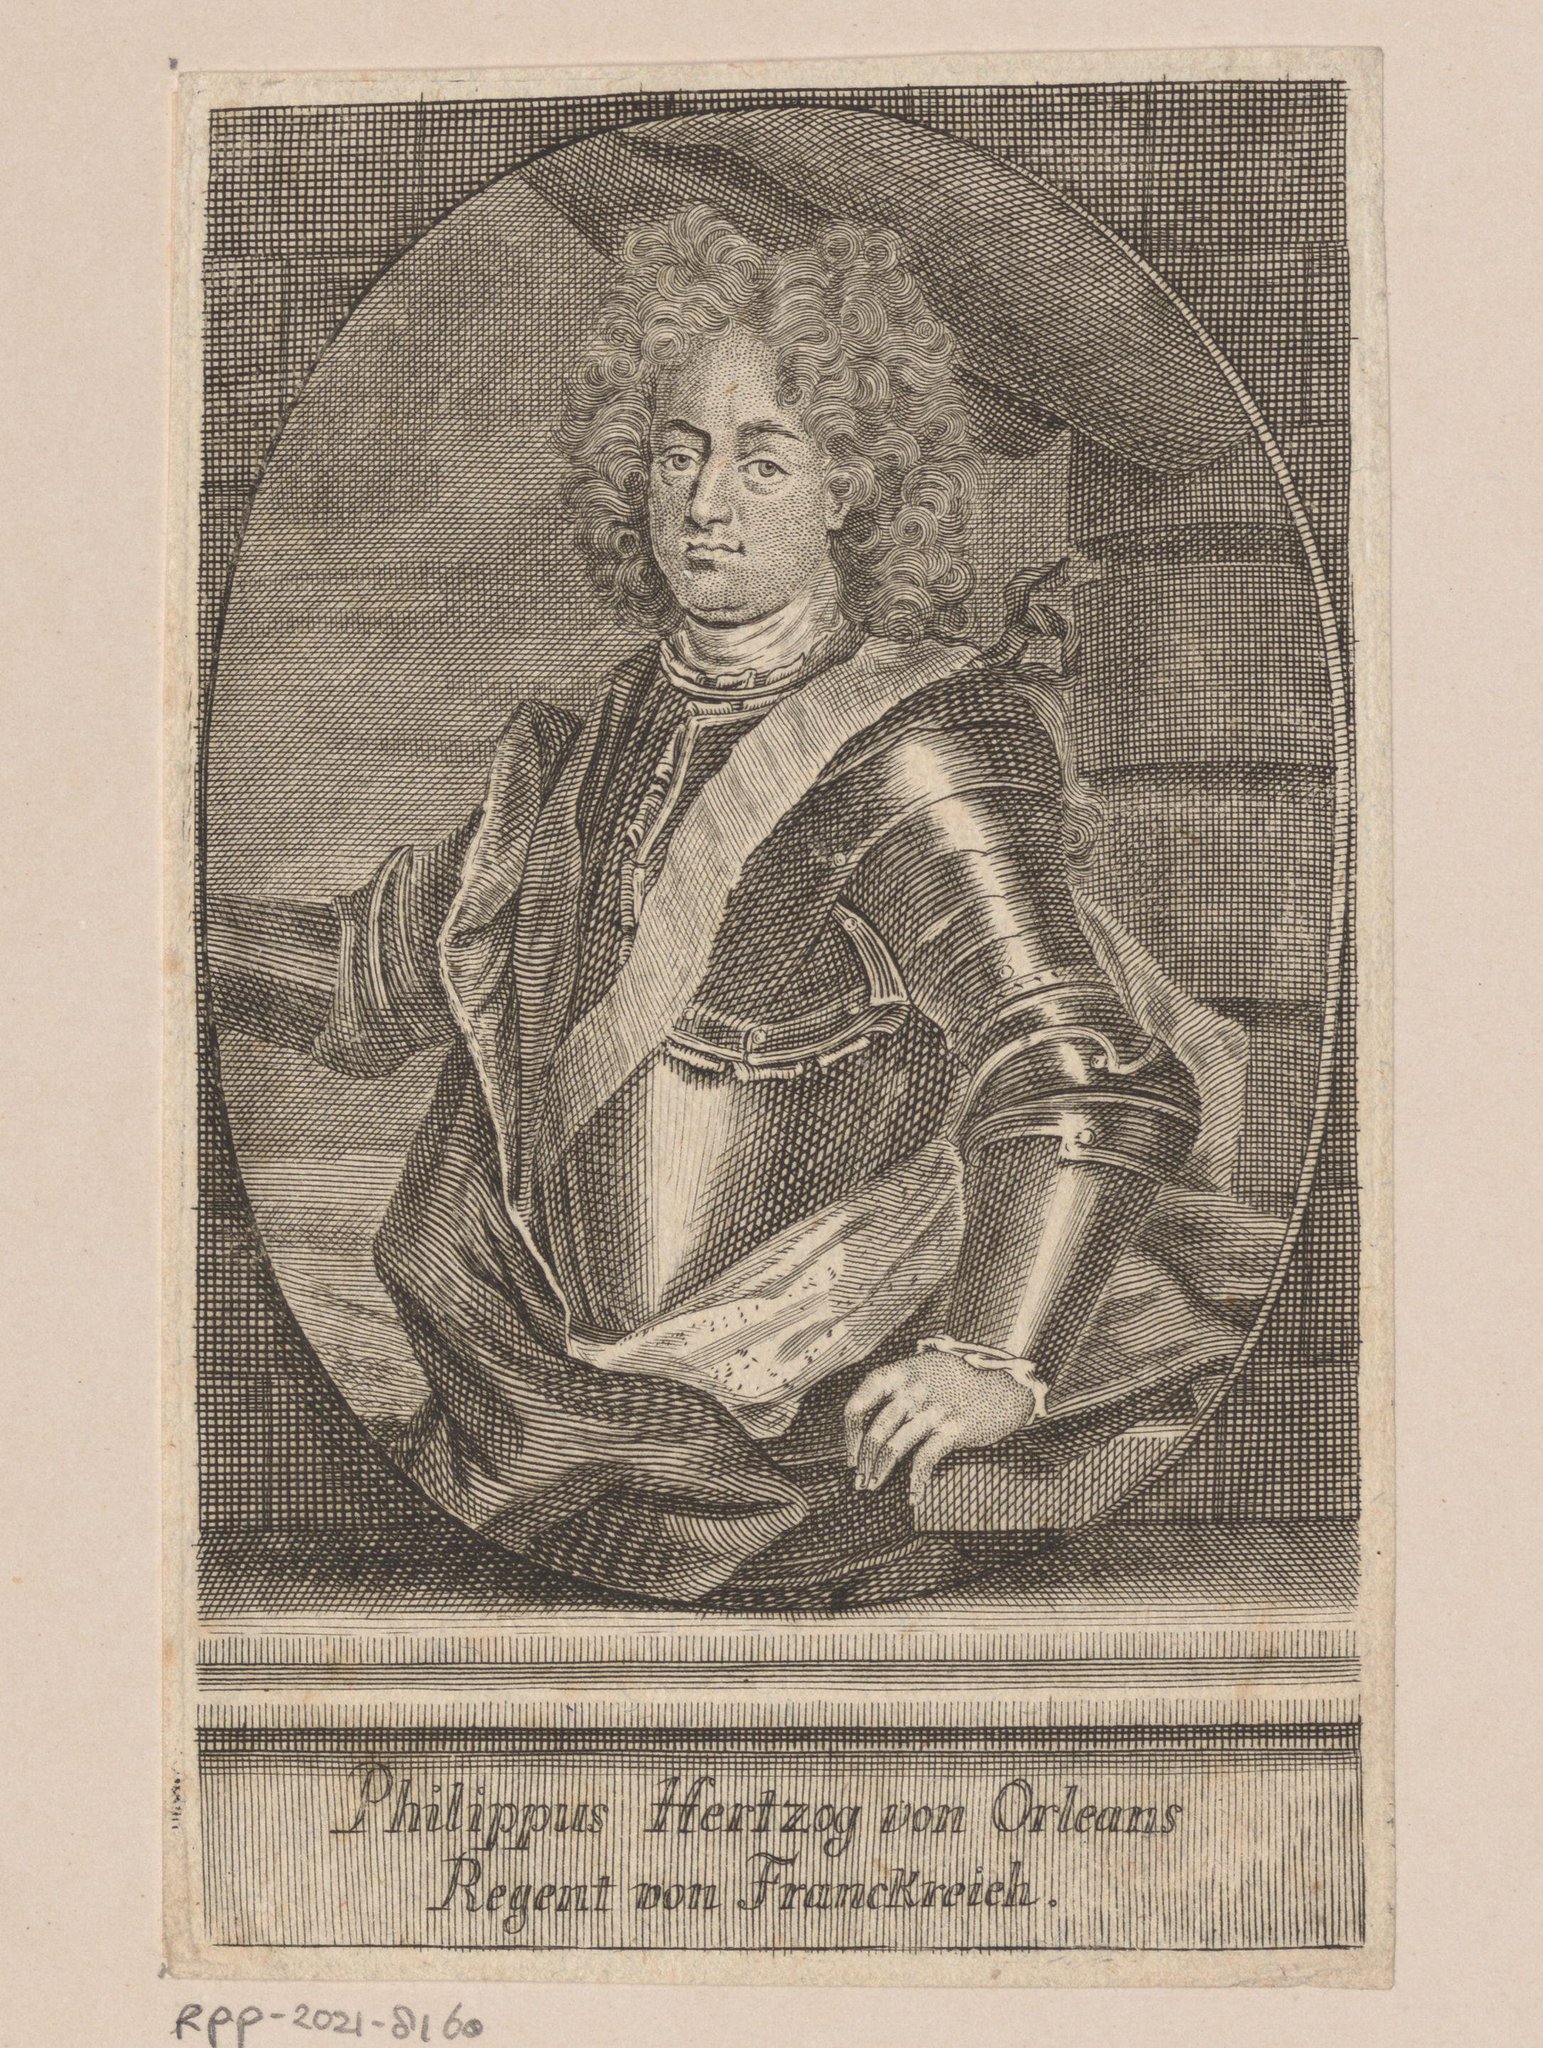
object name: print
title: Portret van Filips II, hertog van Orléans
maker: Anonymous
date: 1700-1749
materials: paper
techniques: engraving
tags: filips ii (hertog van orléans), armour, adult man, historical persons